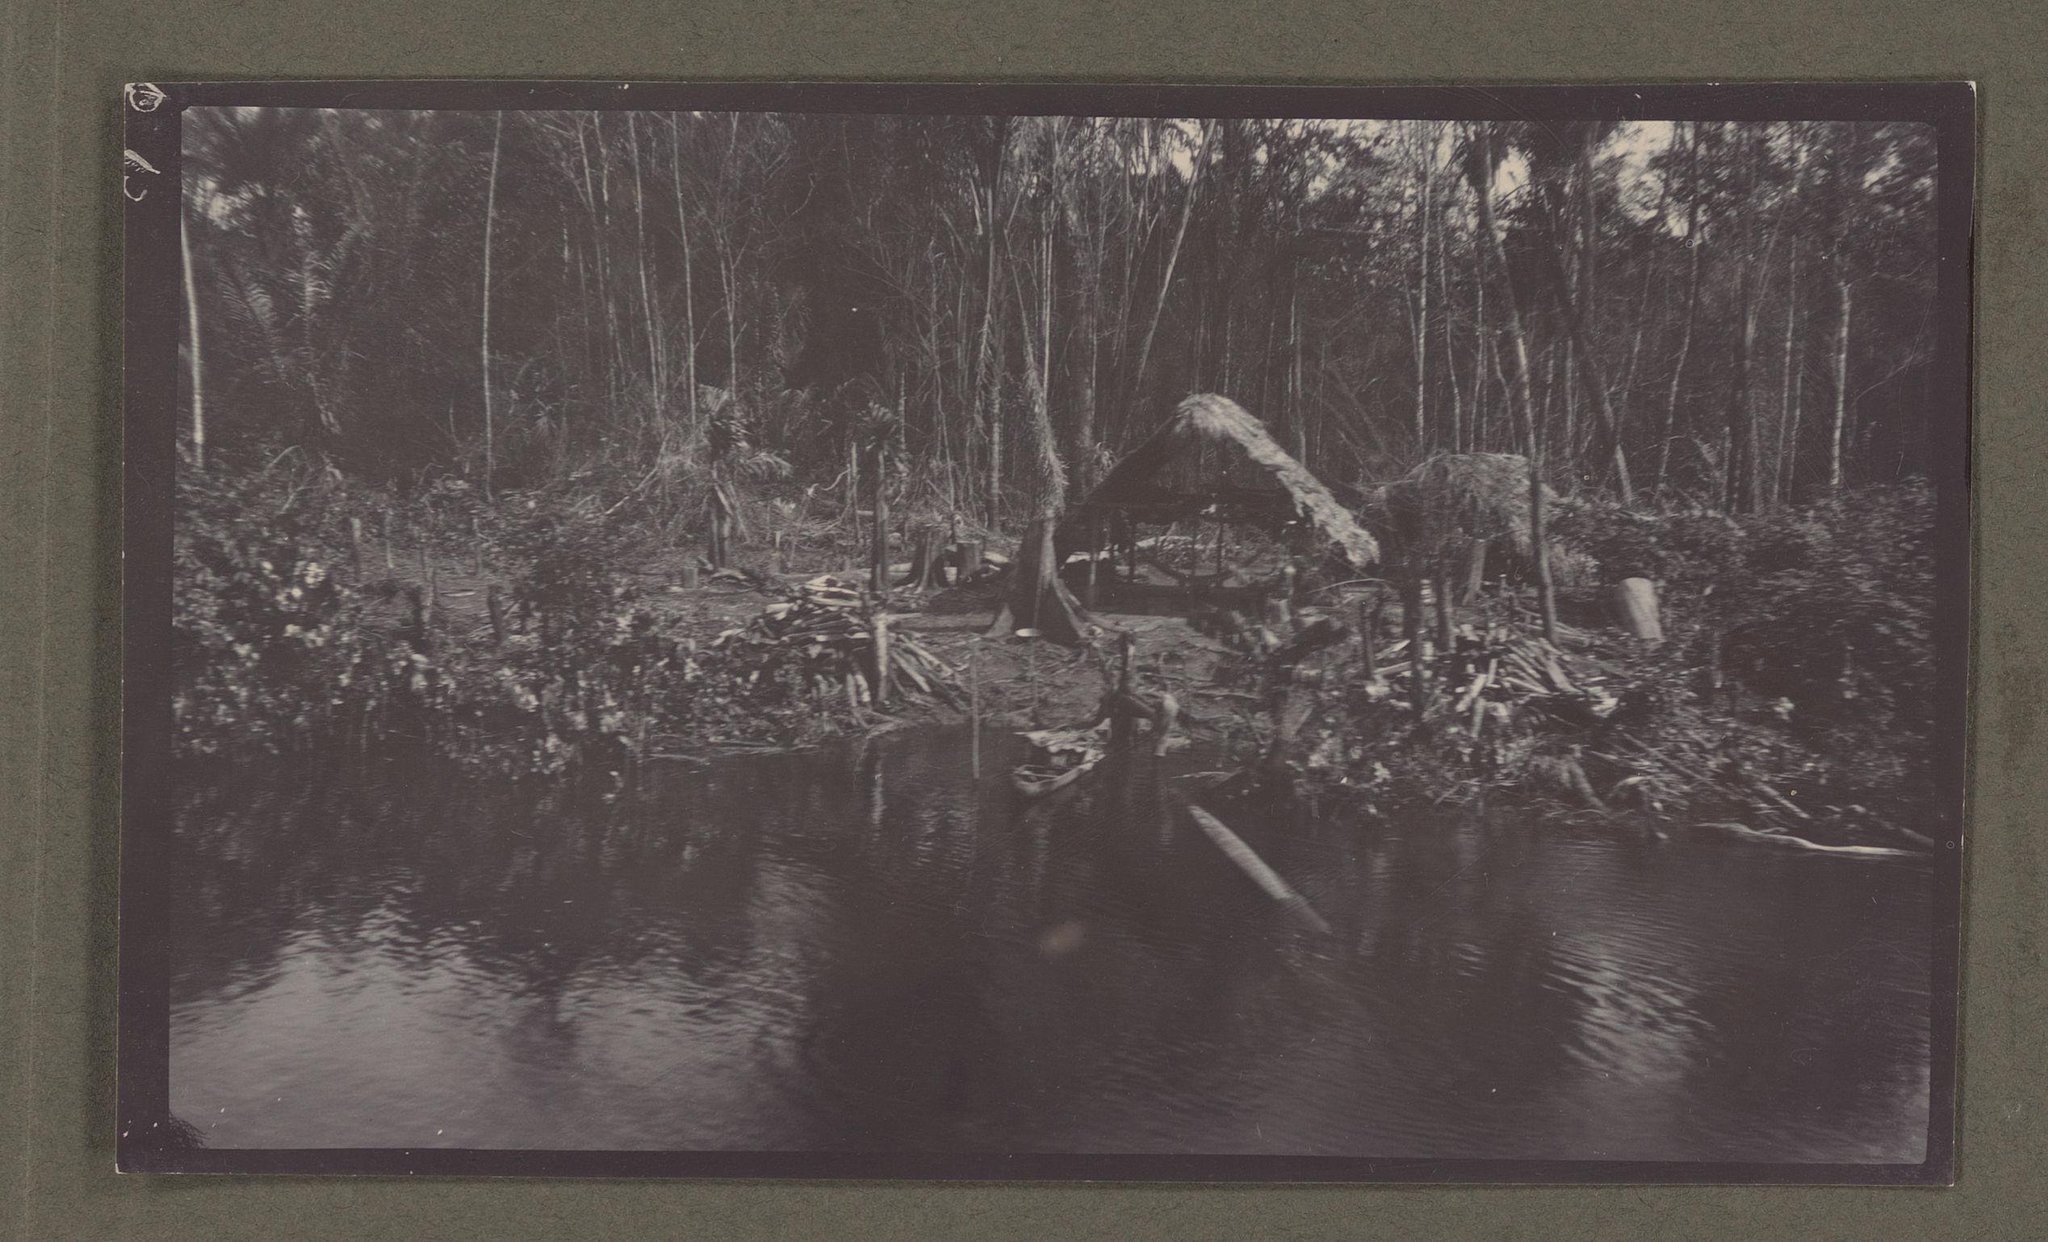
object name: photograph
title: Hutten aan de oever van de rivier Cottica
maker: Anonymous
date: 1925-1927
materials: photographic support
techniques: photography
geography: suriname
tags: jetten, familie, moengo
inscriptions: inscription: ‘Cottica River’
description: Gezicht vanuit een boot op hutten aan de oever van de rivier Cottica. Foto op een bladzijde van een los albumblad. Onderdeel van het ensemble met foto's van de familie van ingenieur Jetten in de mijnbouwstad Moengo in Suriname.